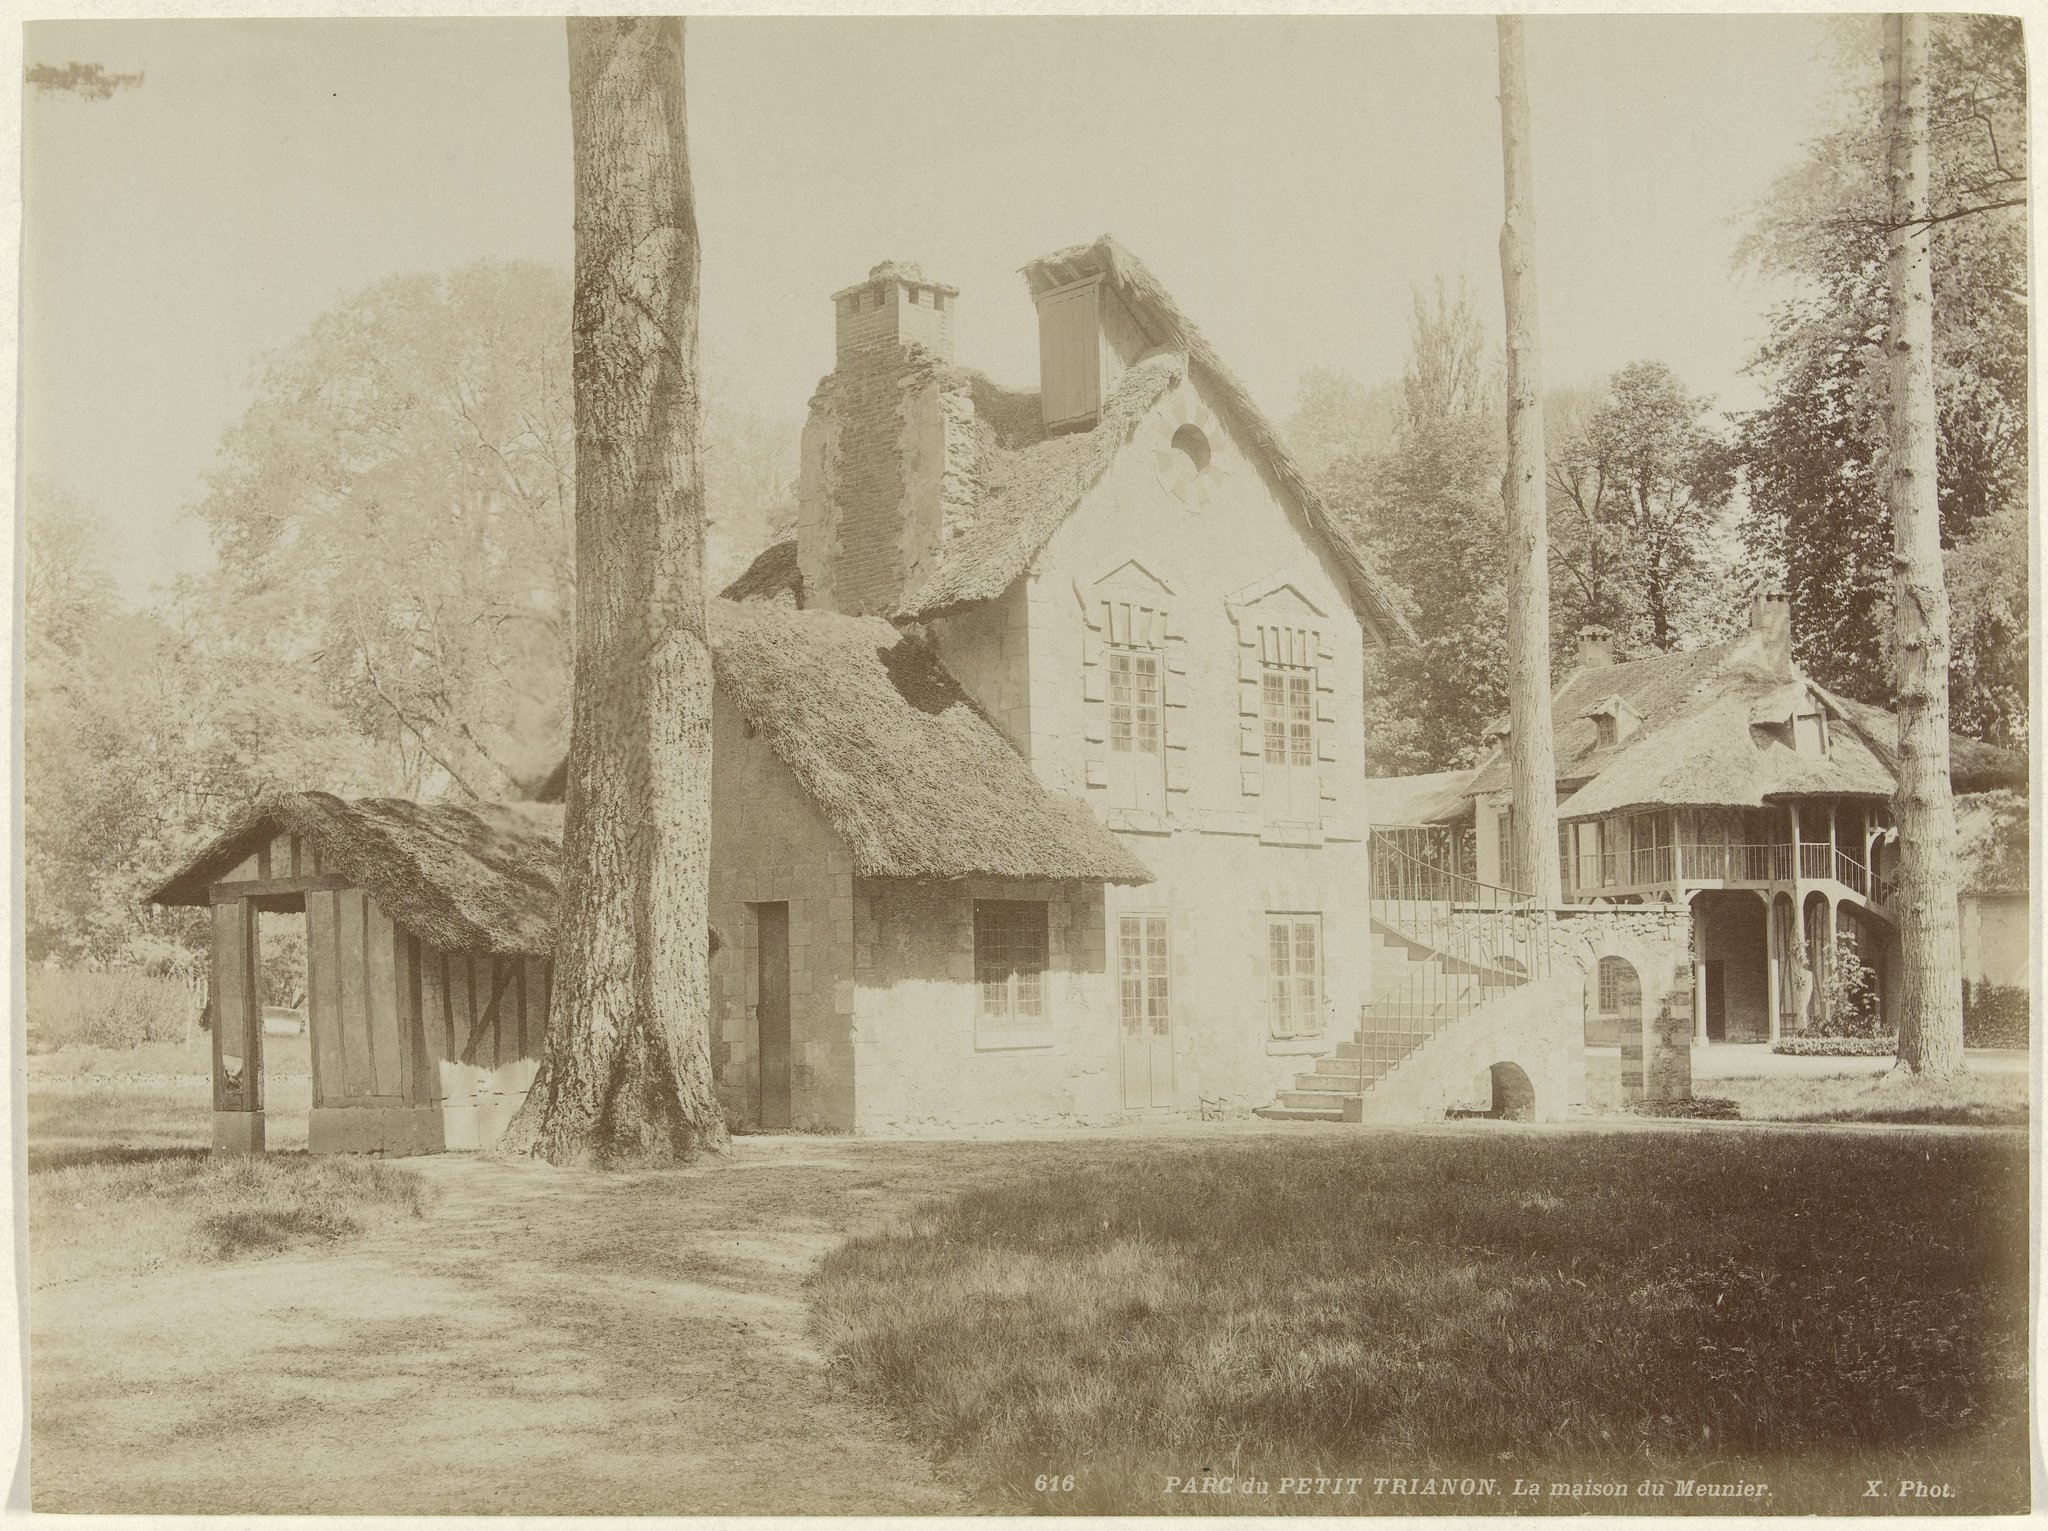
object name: photograph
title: Molenaarshuis bij het Klein Trianon in de tuinen van Versailles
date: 1887-1900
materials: paper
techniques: albumen print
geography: versailles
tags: garden, cottage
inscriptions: inscription: ‘616 Parc du Petit Trianon. La Maison du Meunier. X. Phot.’, number: ‘14’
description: Tussen 1887 en ca. 1900 werkten Neurdein frères onder andere onder de naam 'X phot.'.